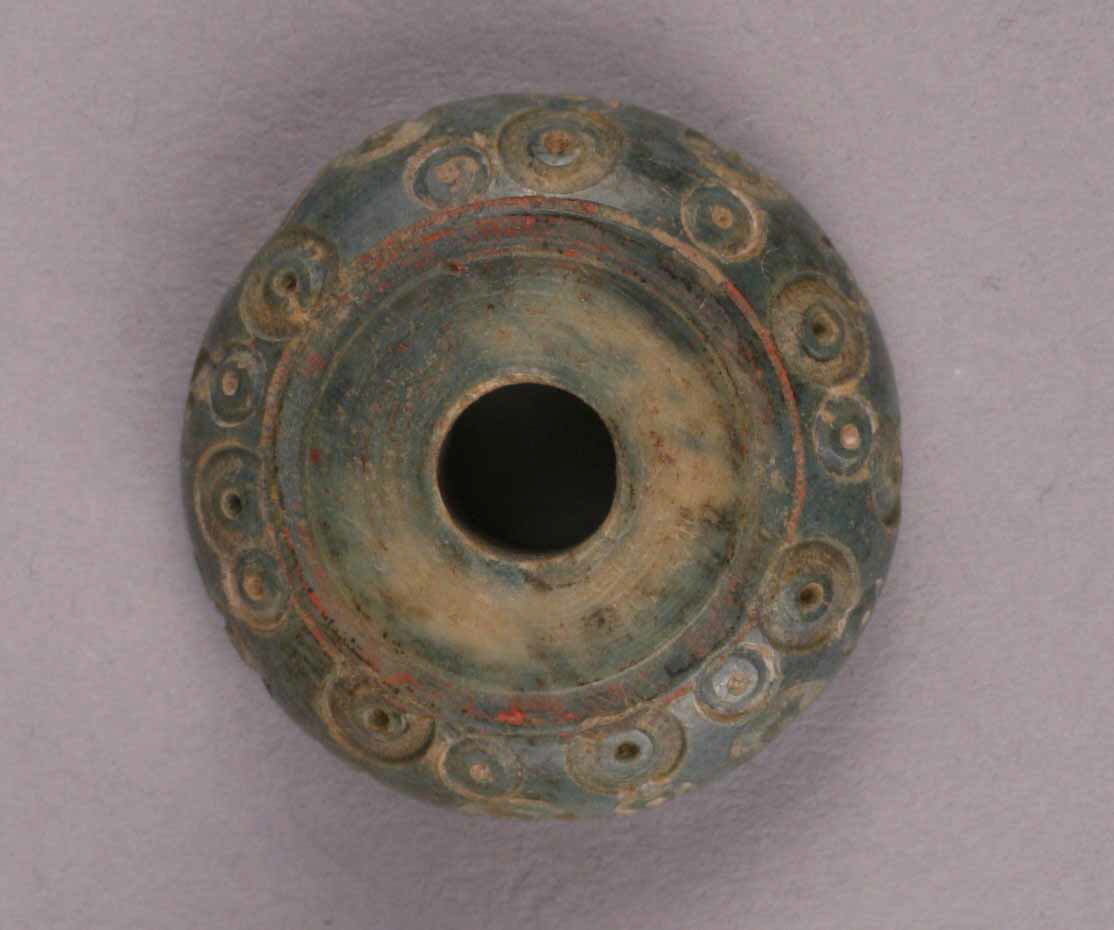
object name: spindle whorl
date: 801-1000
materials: bone, paint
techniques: incising, inlay, tinting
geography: iran